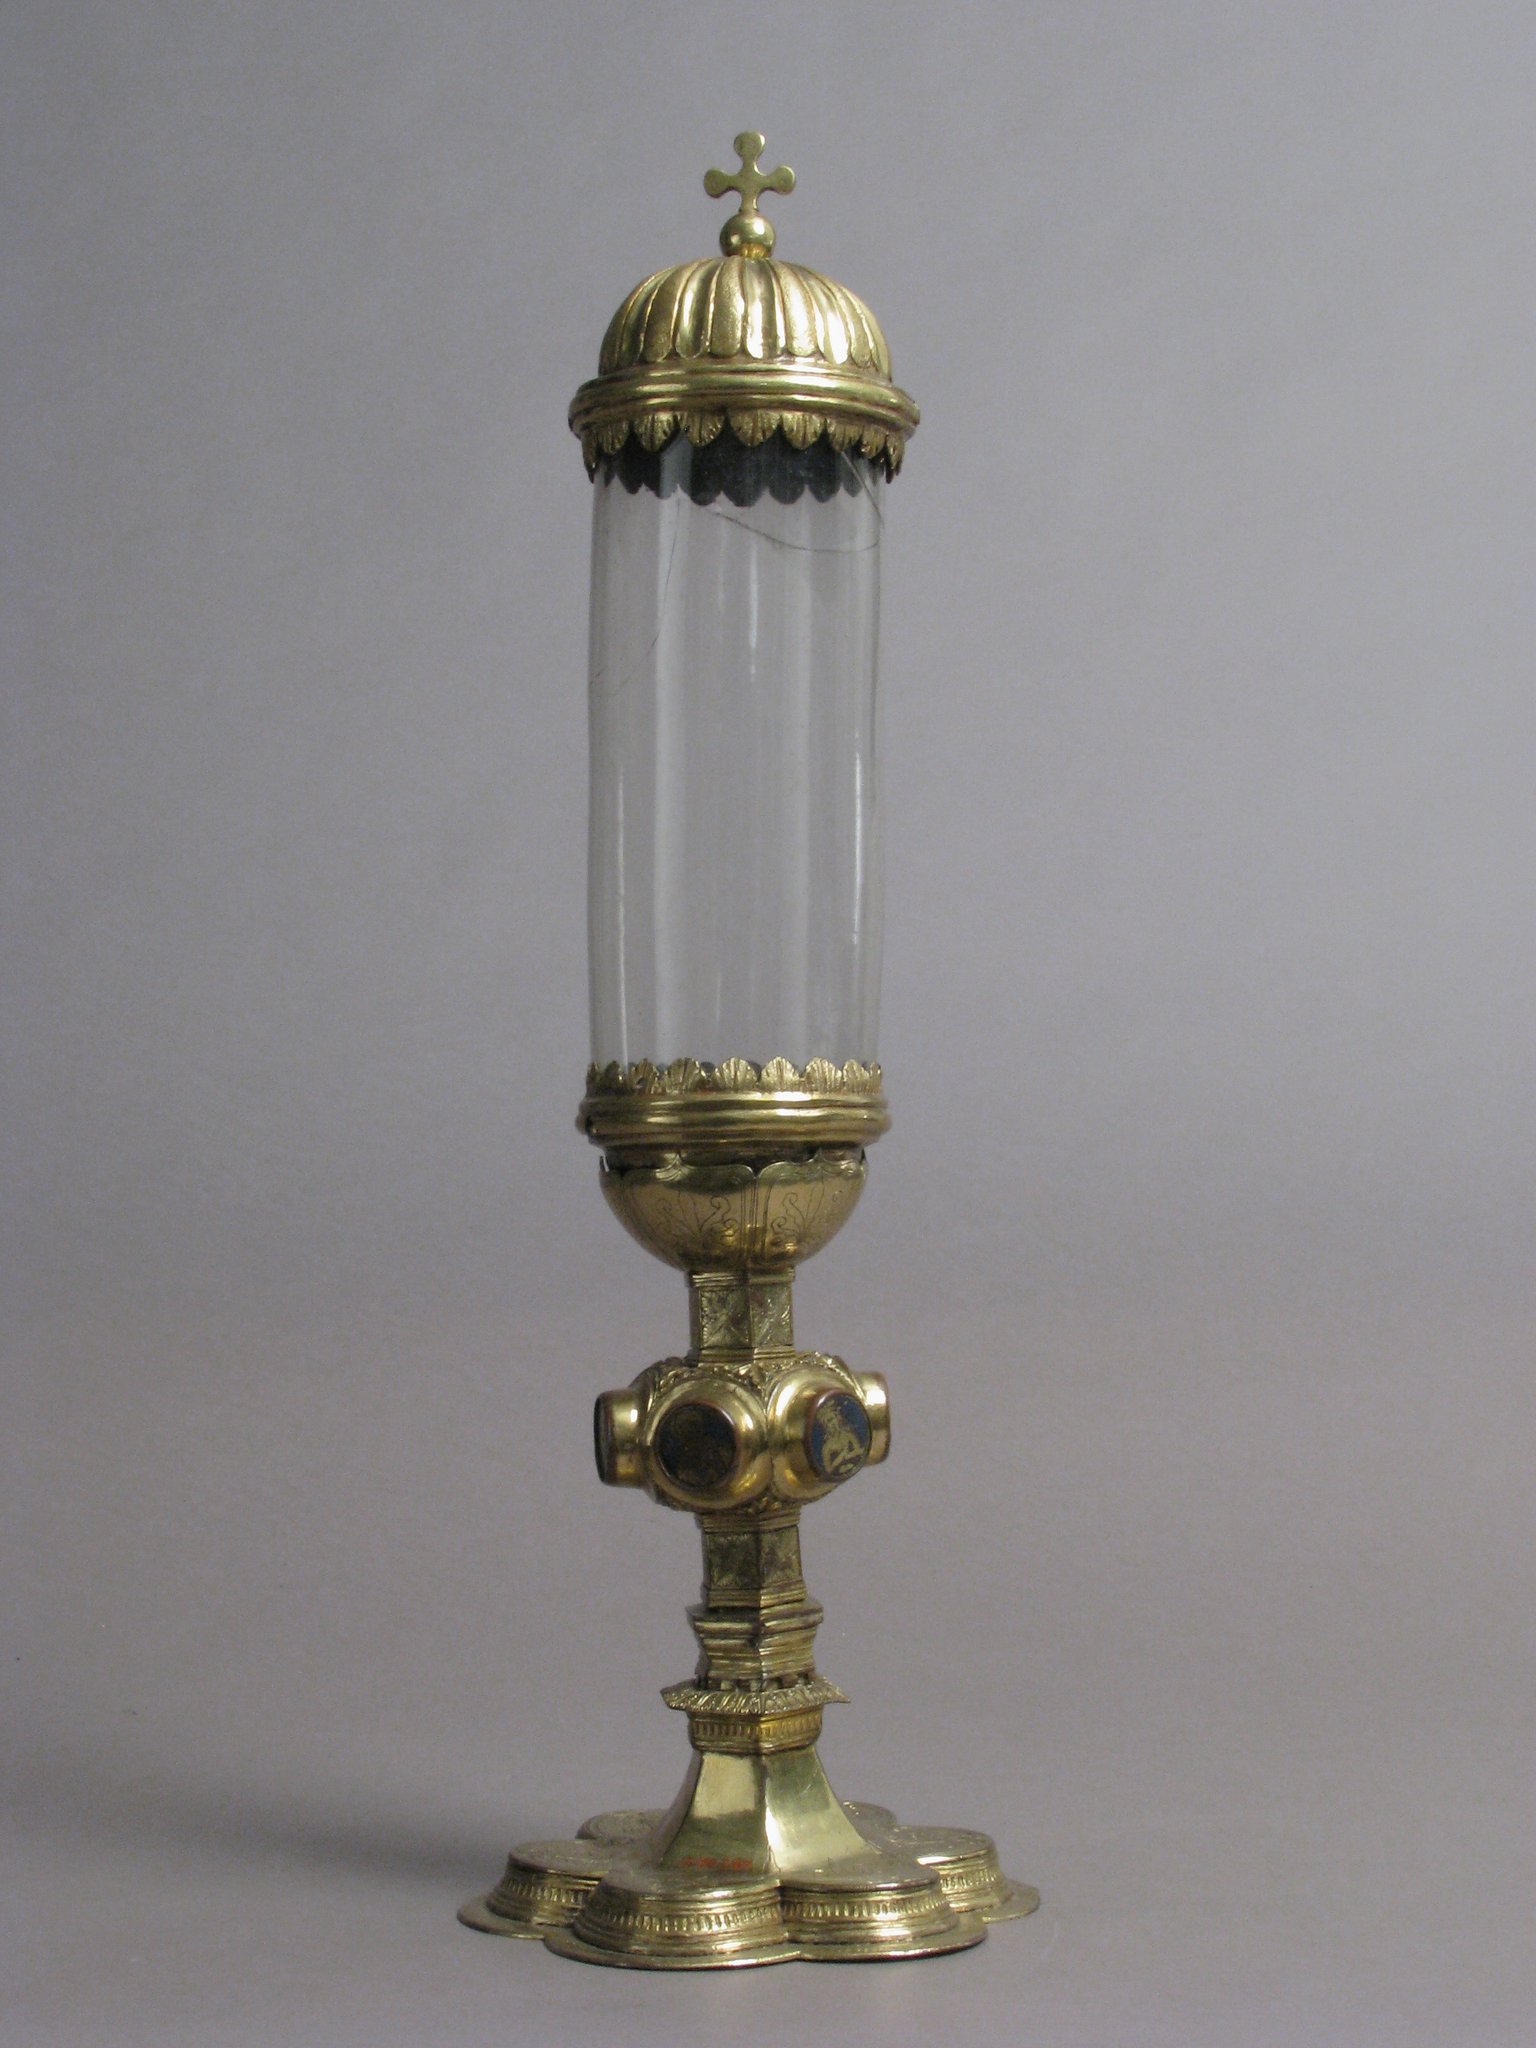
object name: reliquary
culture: italian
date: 1501-1600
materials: gilt copper, enamel, glass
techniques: enamel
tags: cross